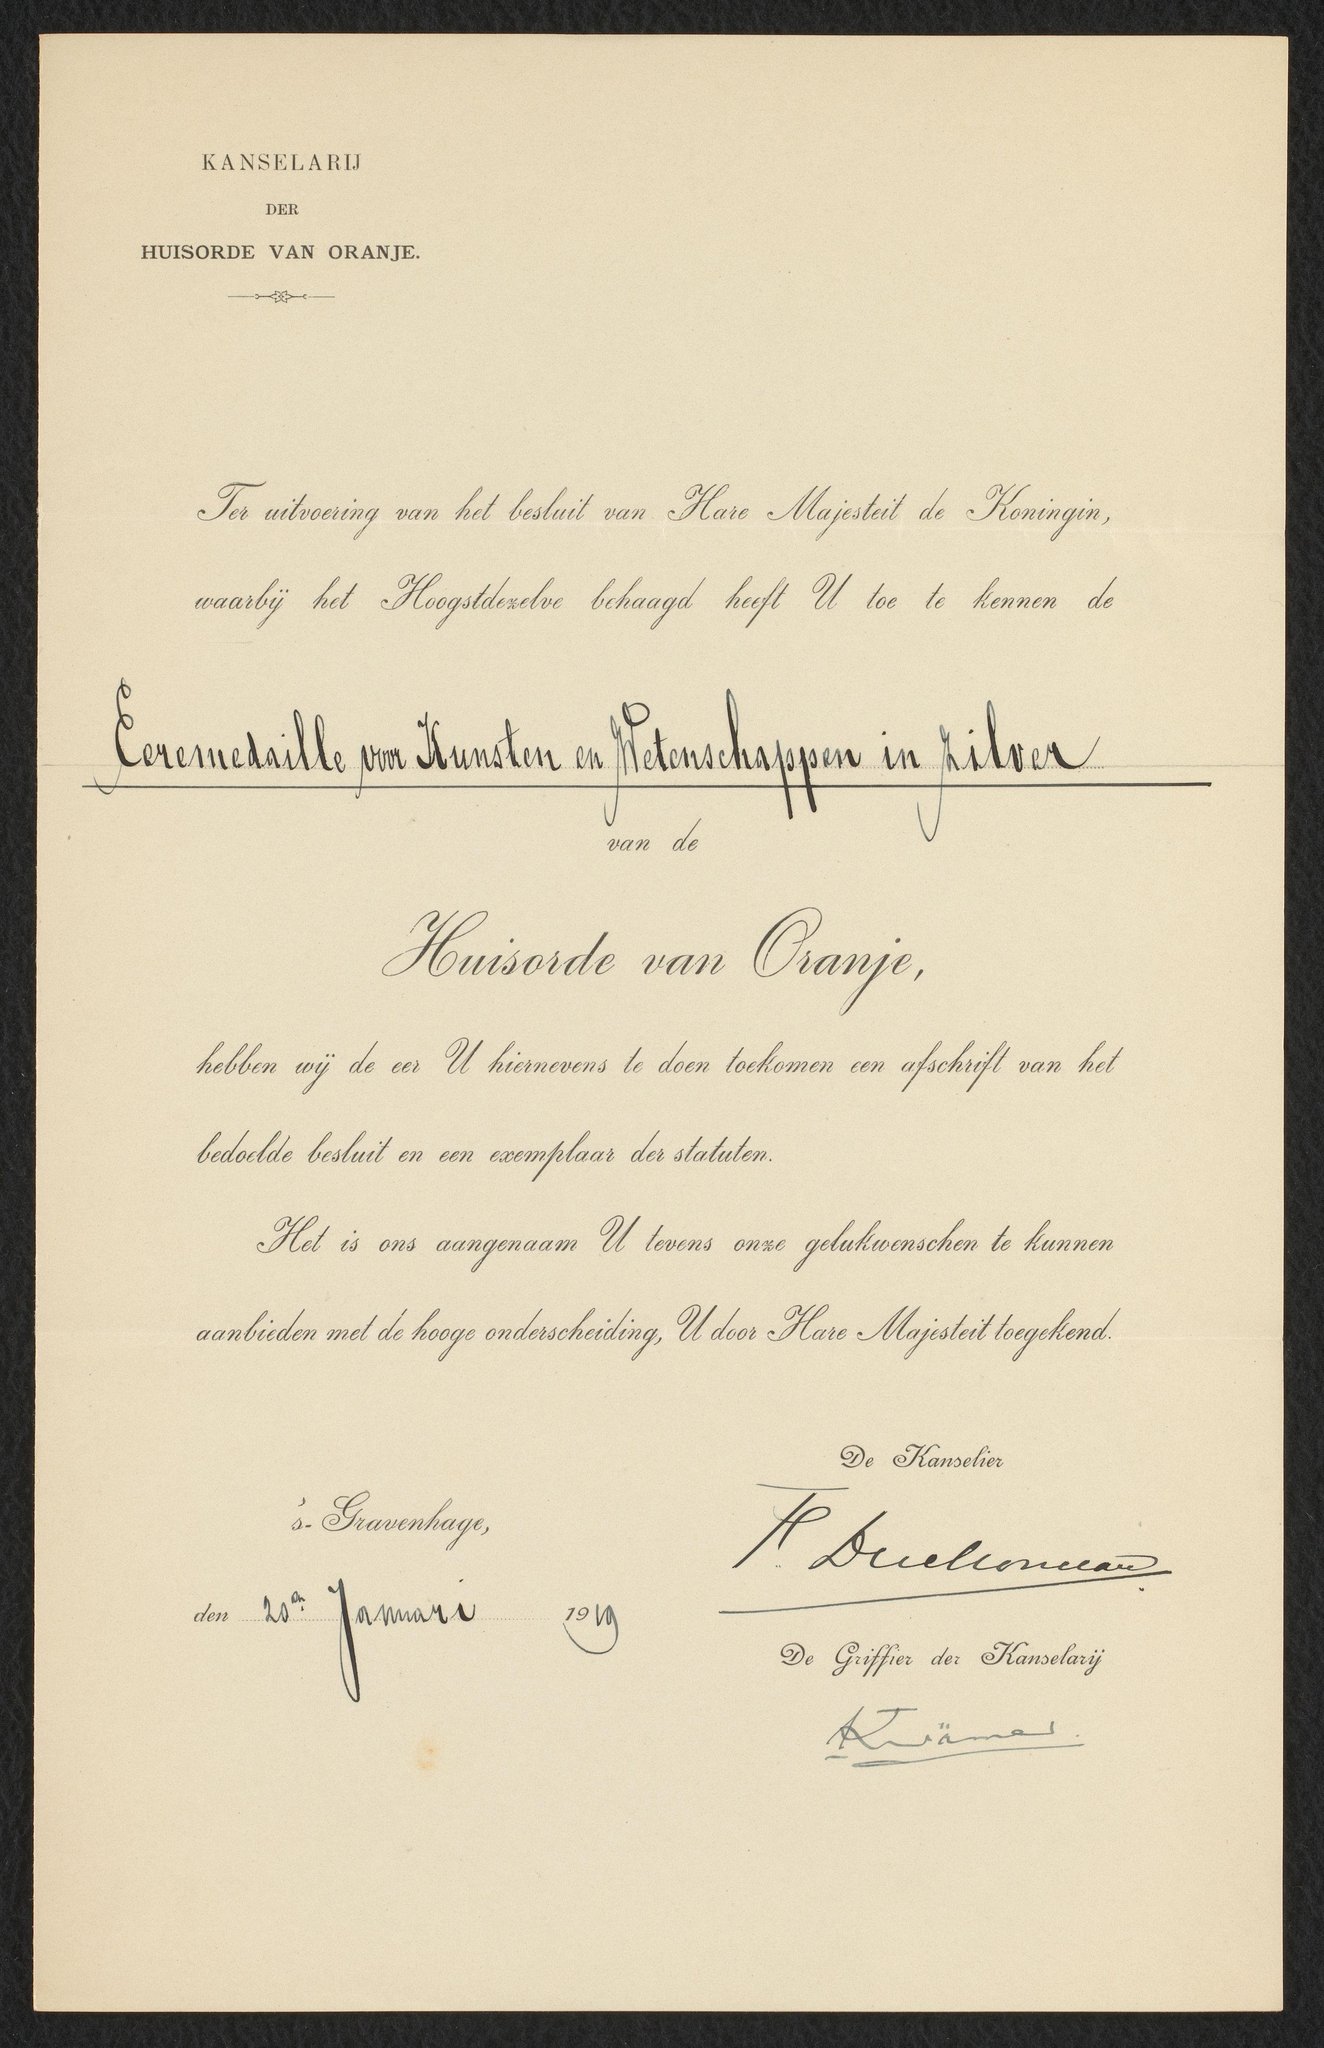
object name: document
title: Afschrift behorende bij de Eremedaille voor kunsten en wetenschappen in zilver van de Huisorde van Oranje, uitgereikt aan George Hendrik Breitner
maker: Anonymous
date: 1919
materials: ink, paper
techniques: letterpress printing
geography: the hague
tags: rotterdam, amsterdam, painter, print maker, draughtsman, george hendrik breitner, distribution of awards ~ art contest